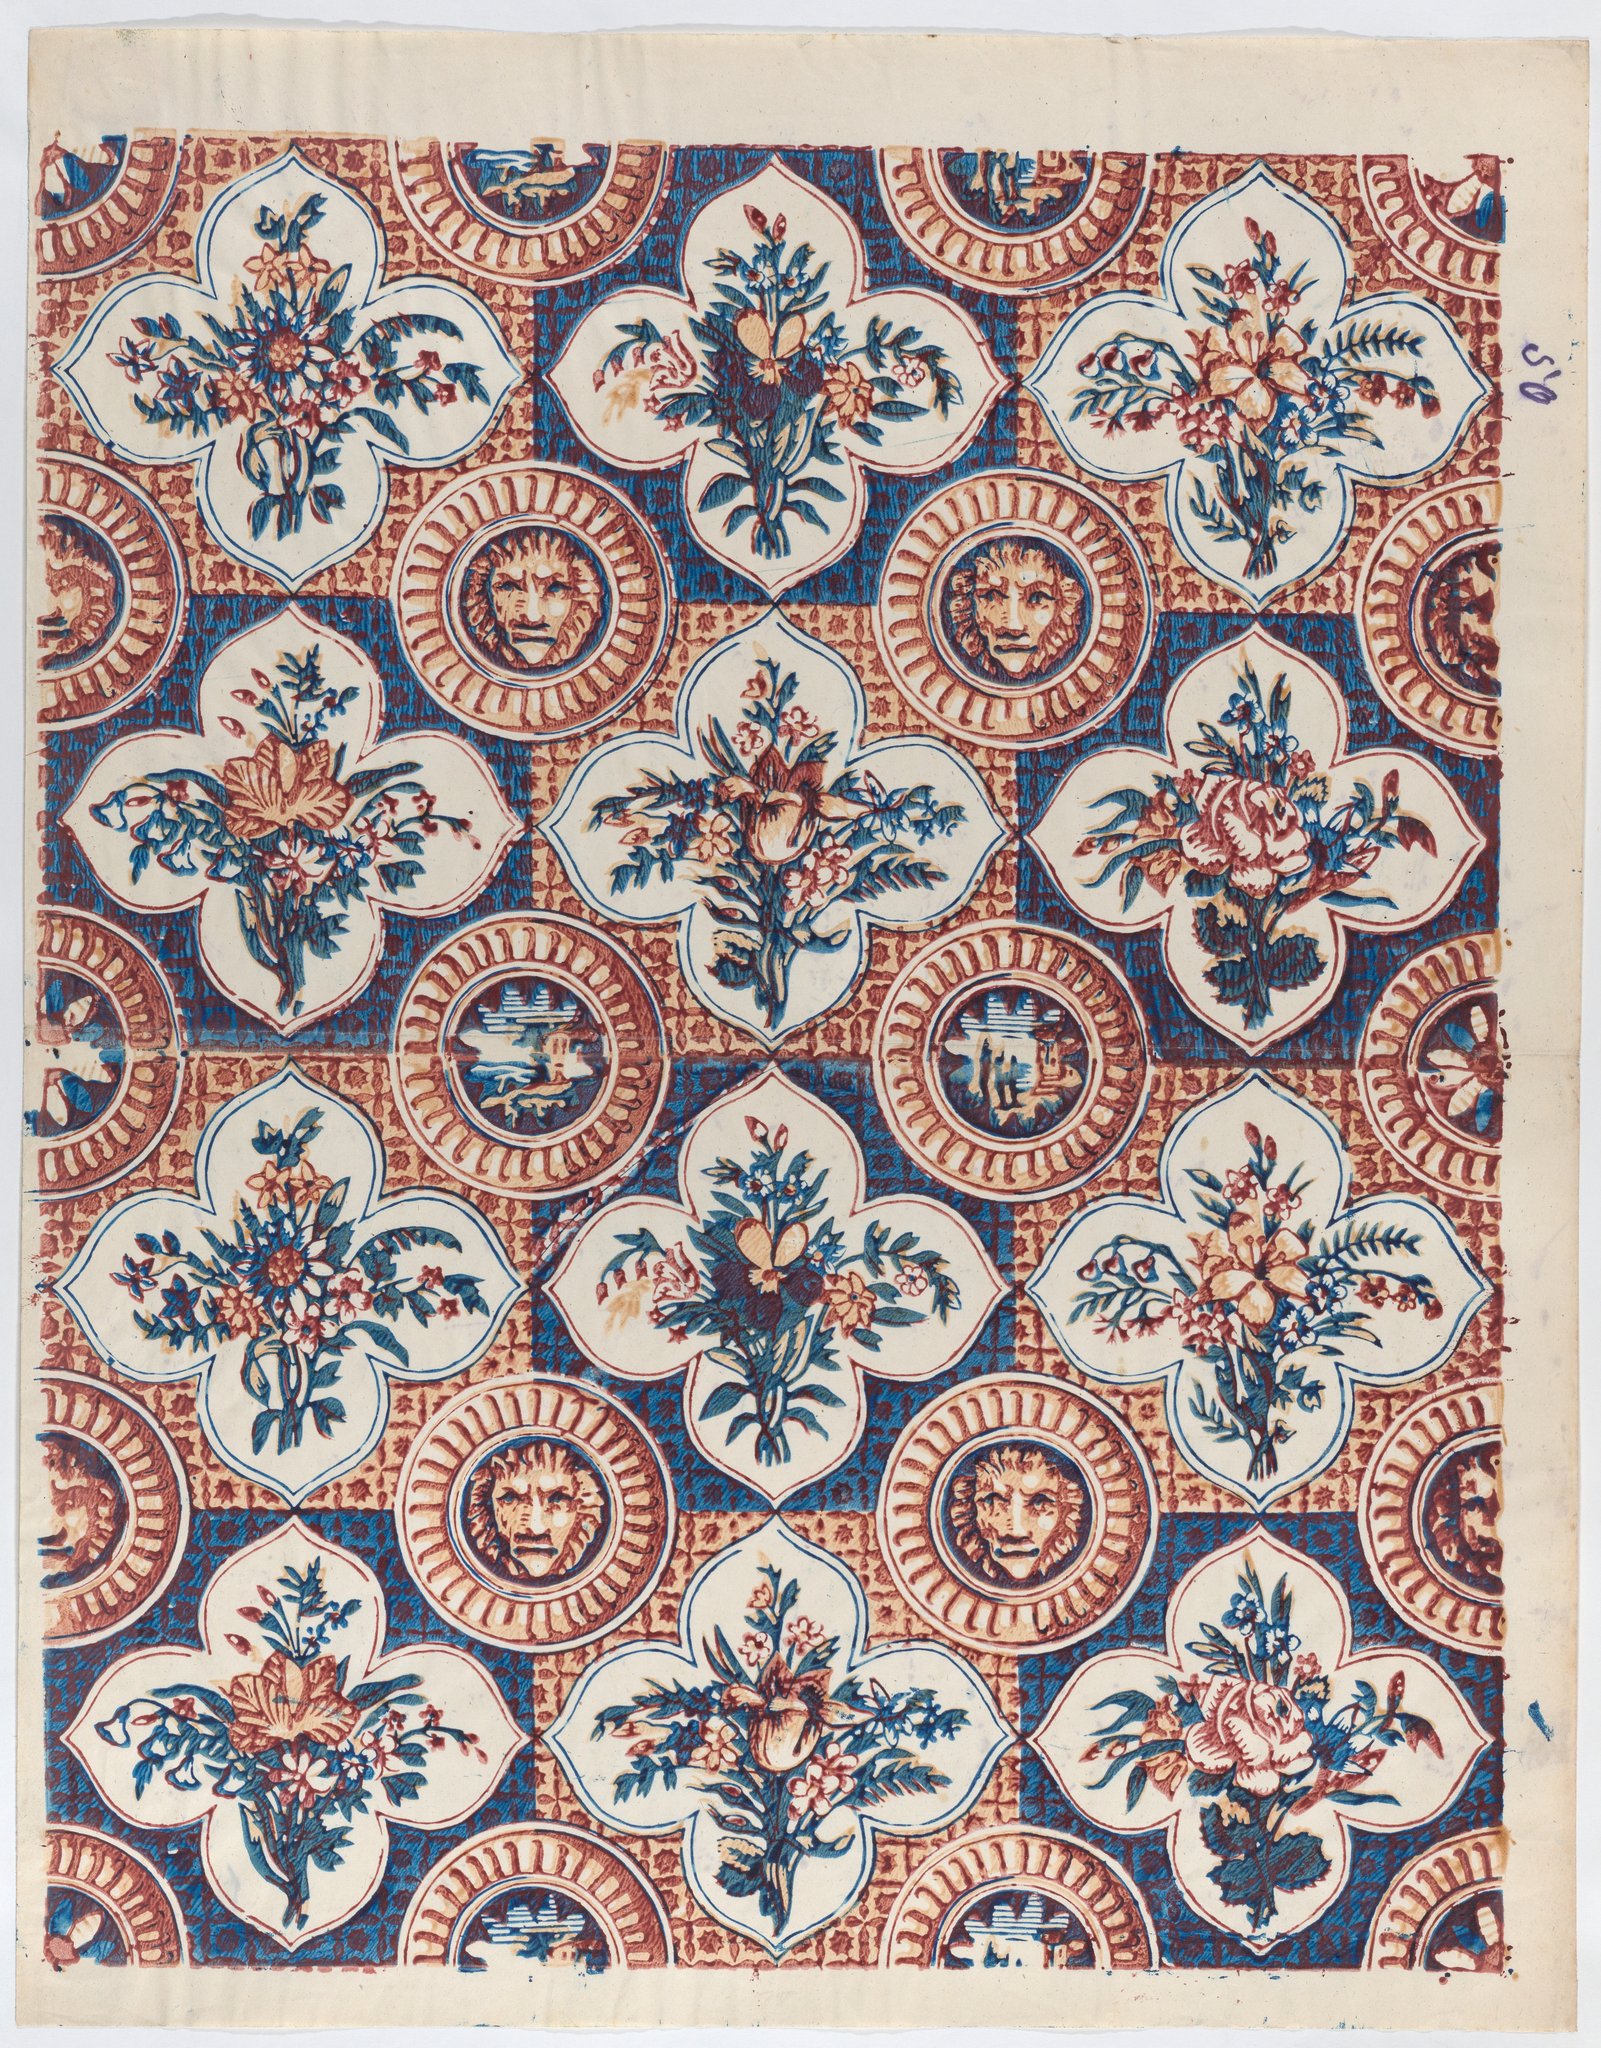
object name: print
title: Sheet with pattern of bouquets and lion heads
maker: Anonymous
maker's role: artist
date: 1767-1866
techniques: relief print